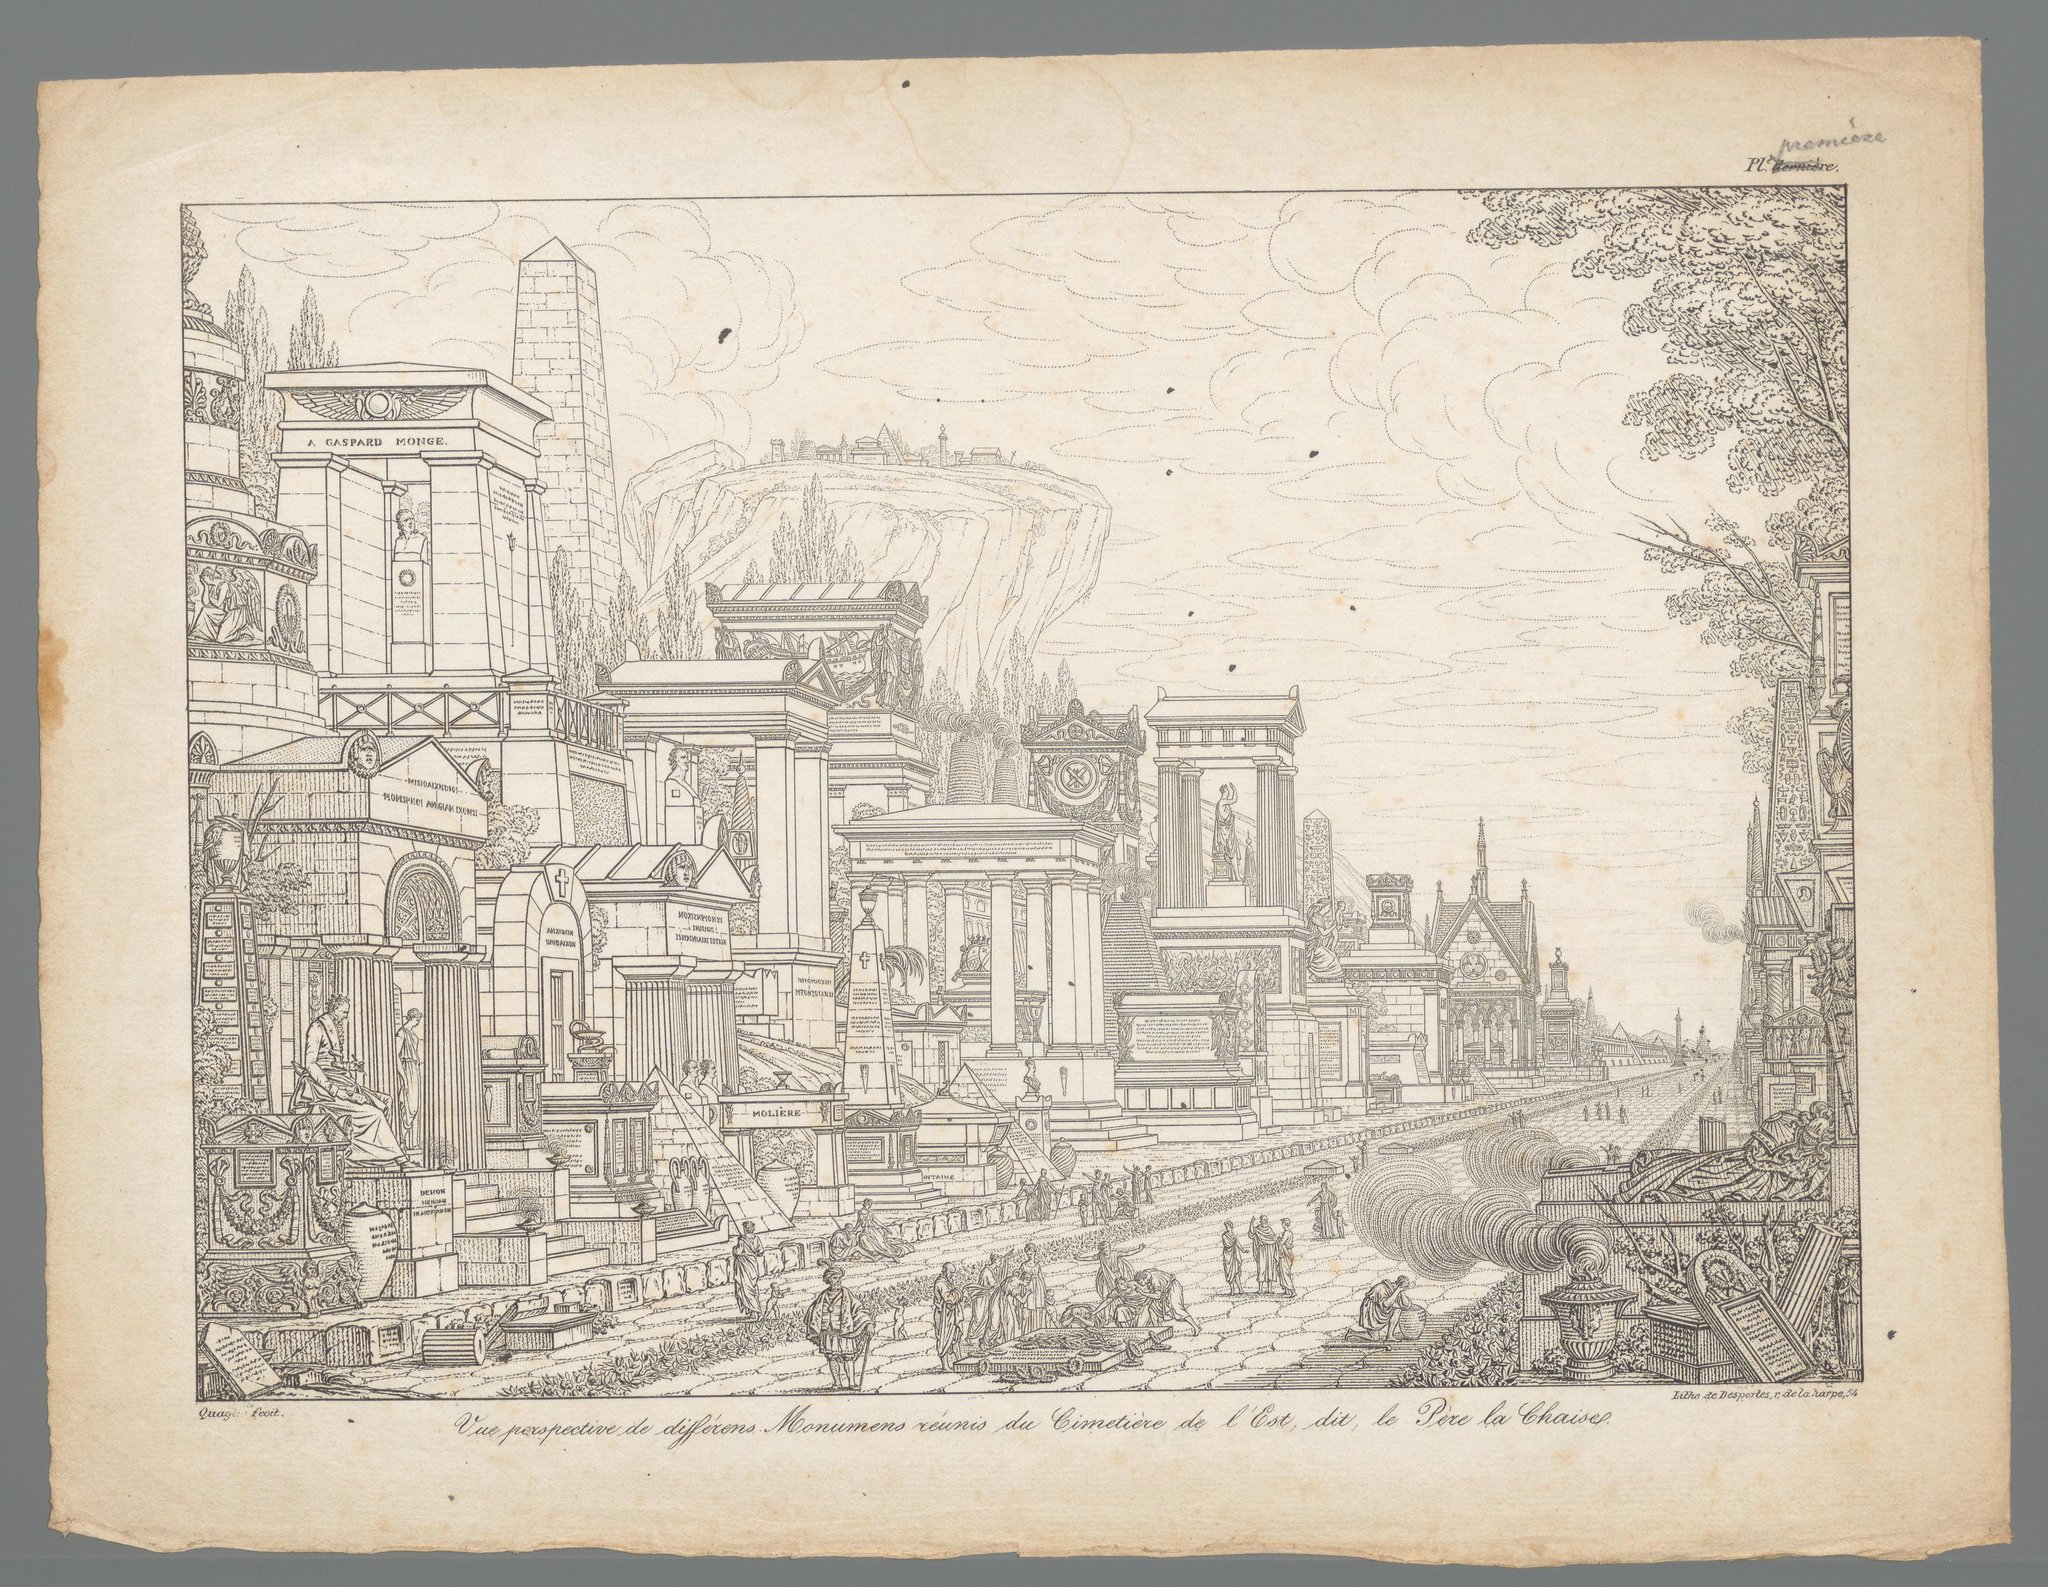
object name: print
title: Gezichten op het Cimetière du Père-Lachaise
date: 1803-1869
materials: paper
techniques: lithograph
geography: paris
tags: cemetery, park-like burying ground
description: Prent maakt deel uit van een serie van twintig prenten, waarvan de twintigste een tekstblad is.